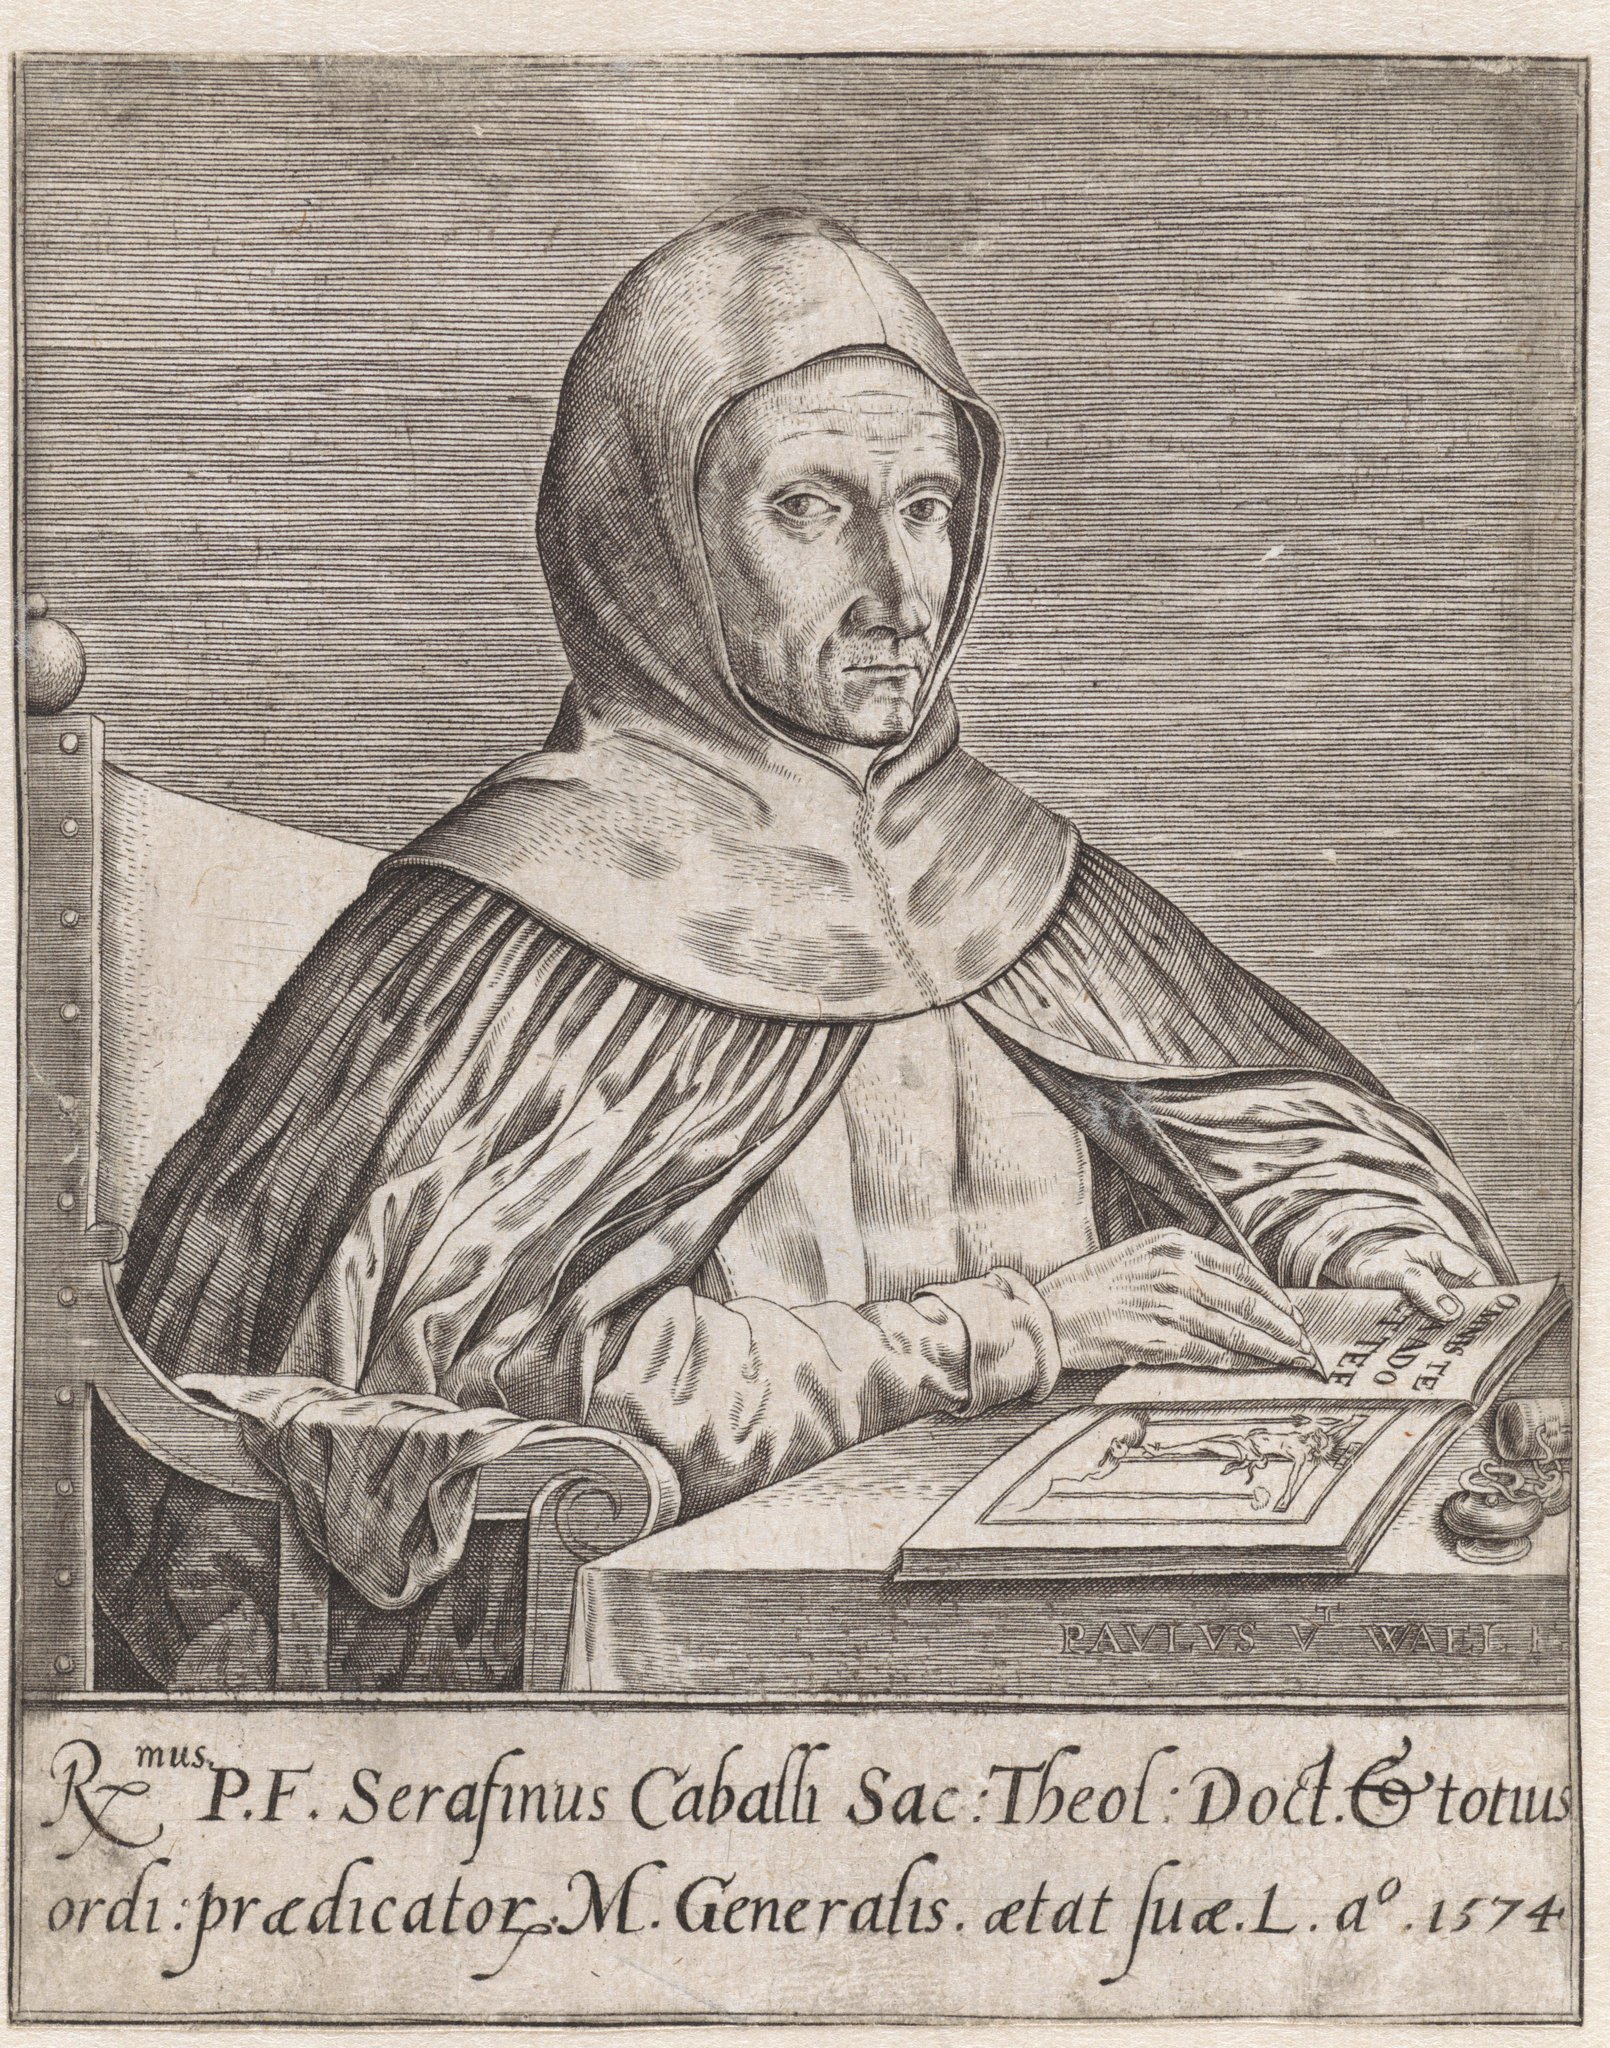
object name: print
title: Portret van Serafinus Caballi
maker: paulus van wtewael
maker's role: die cutter, draughtsman, print maker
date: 1574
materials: paper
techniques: engraving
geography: northern netherlands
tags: specific types of crucified christ (in non-narrative context), writing accessories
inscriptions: collector's mark: Lugt 2228, collector's mark: Lugt 692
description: Portret van de theoloog Serafinus Caballi, op 50-jarige leeftijd. Hij zit aan tafel en schrijft in een boek waarin ook een afbeelding van de gekruisigde Christus staat. In de marge een tweeregelig onderschrift in het Latijn.